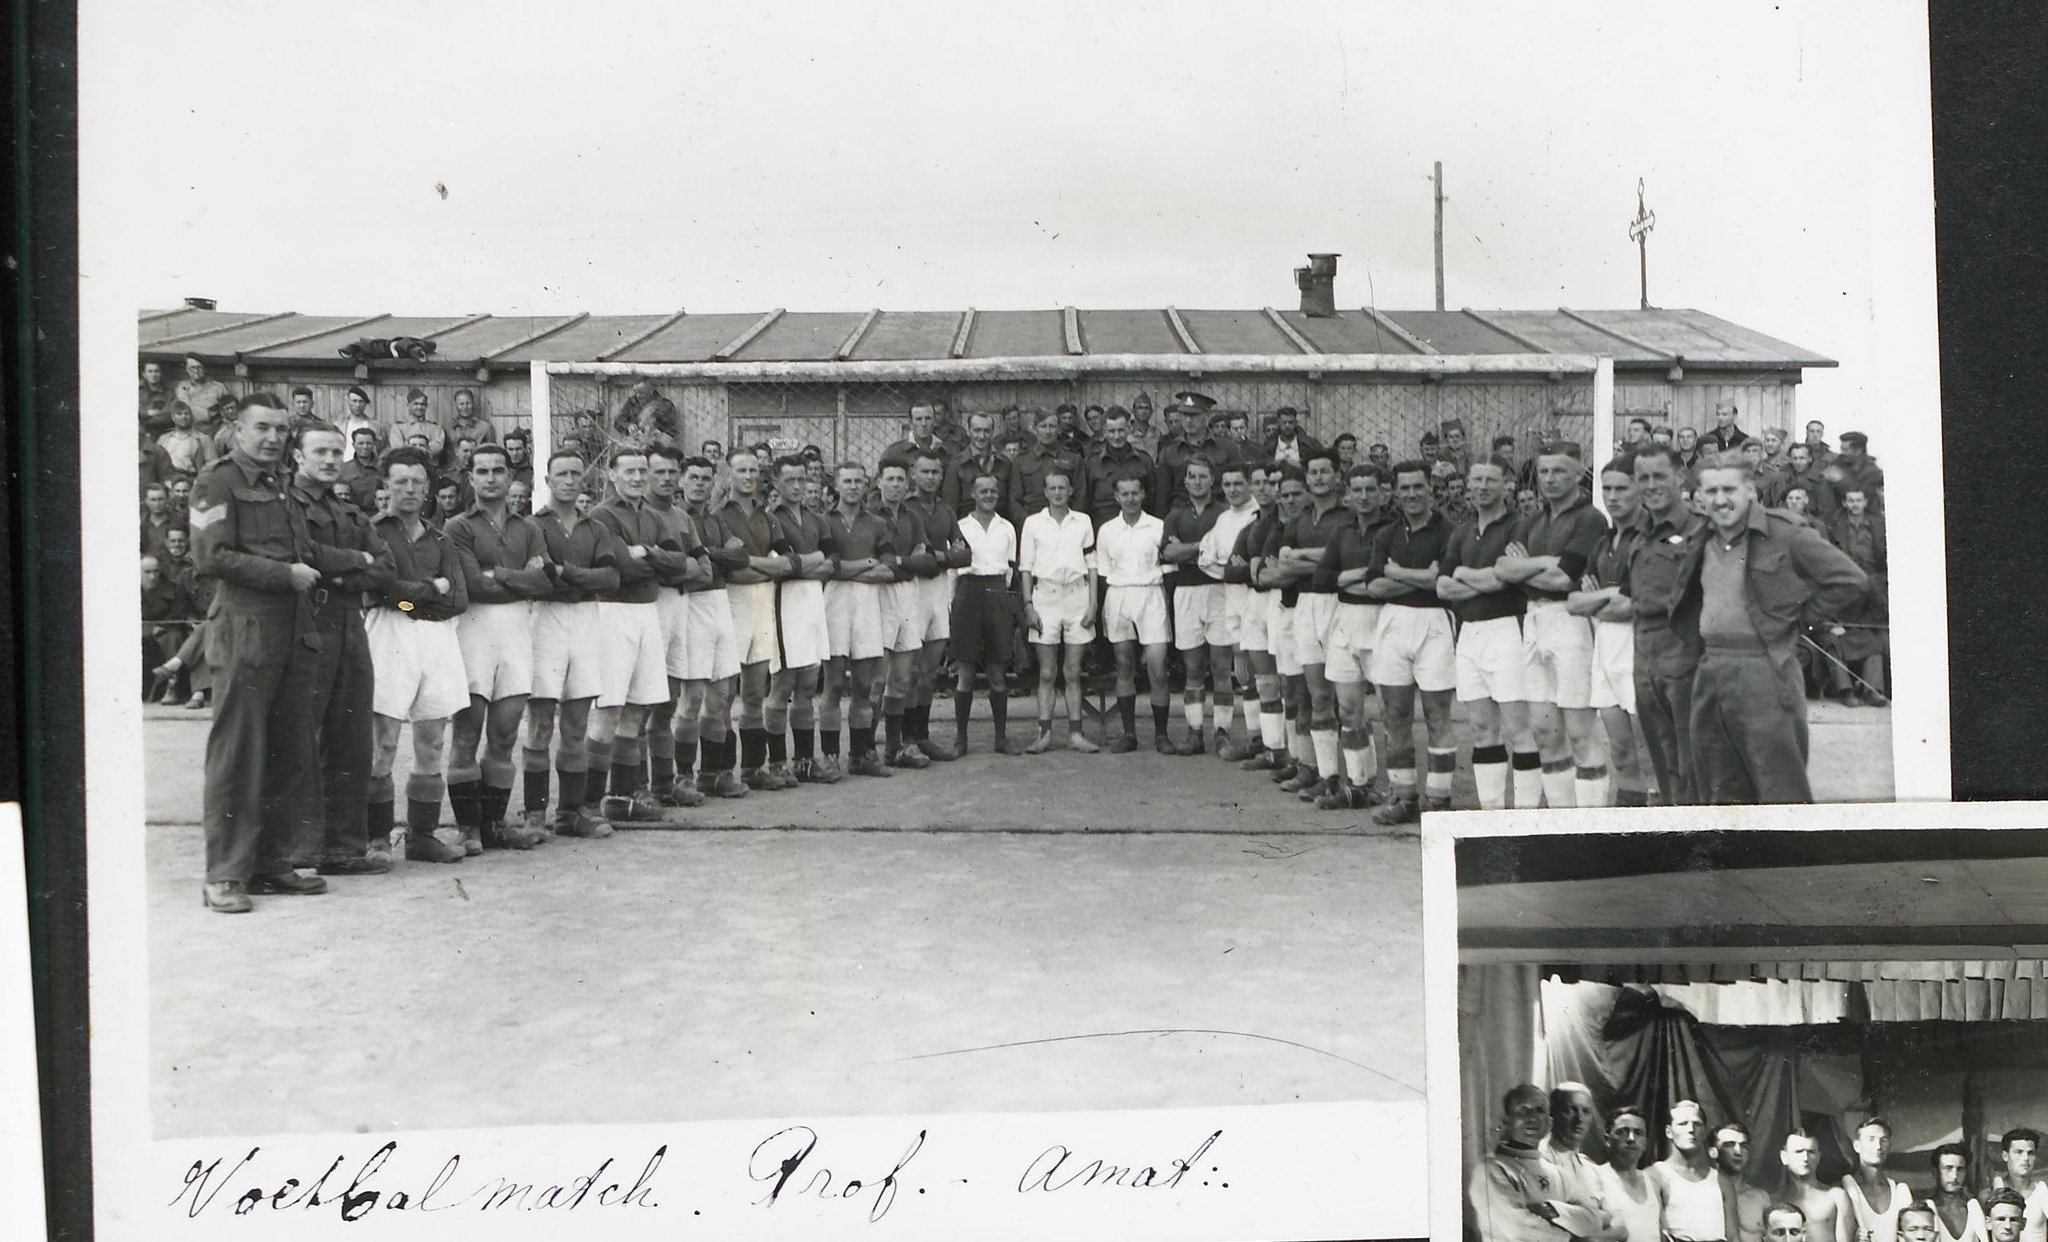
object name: photograph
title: Voetbal match. Prof. - Amat. / V.T. groep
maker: dick w.b. van maarseveen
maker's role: fotograaf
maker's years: 1905-1990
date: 1943-1945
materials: cardboard, photographic support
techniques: gelatin silver print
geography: muhlberg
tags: dick w.b. van maarseveen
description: Albumblad met twee foto’s: groepsfoto van twee voetbalelftallen van professionals en amateurs en een groepsfoto van een groep van schermers, boksers, gymnasten en muzikanten. Onderdeel van een fotoalbum met foto's door Dick van Maarseveen van het krijgsgevangenenkamp Stalag IV B in Mühlberg in de periode 1943-1945.